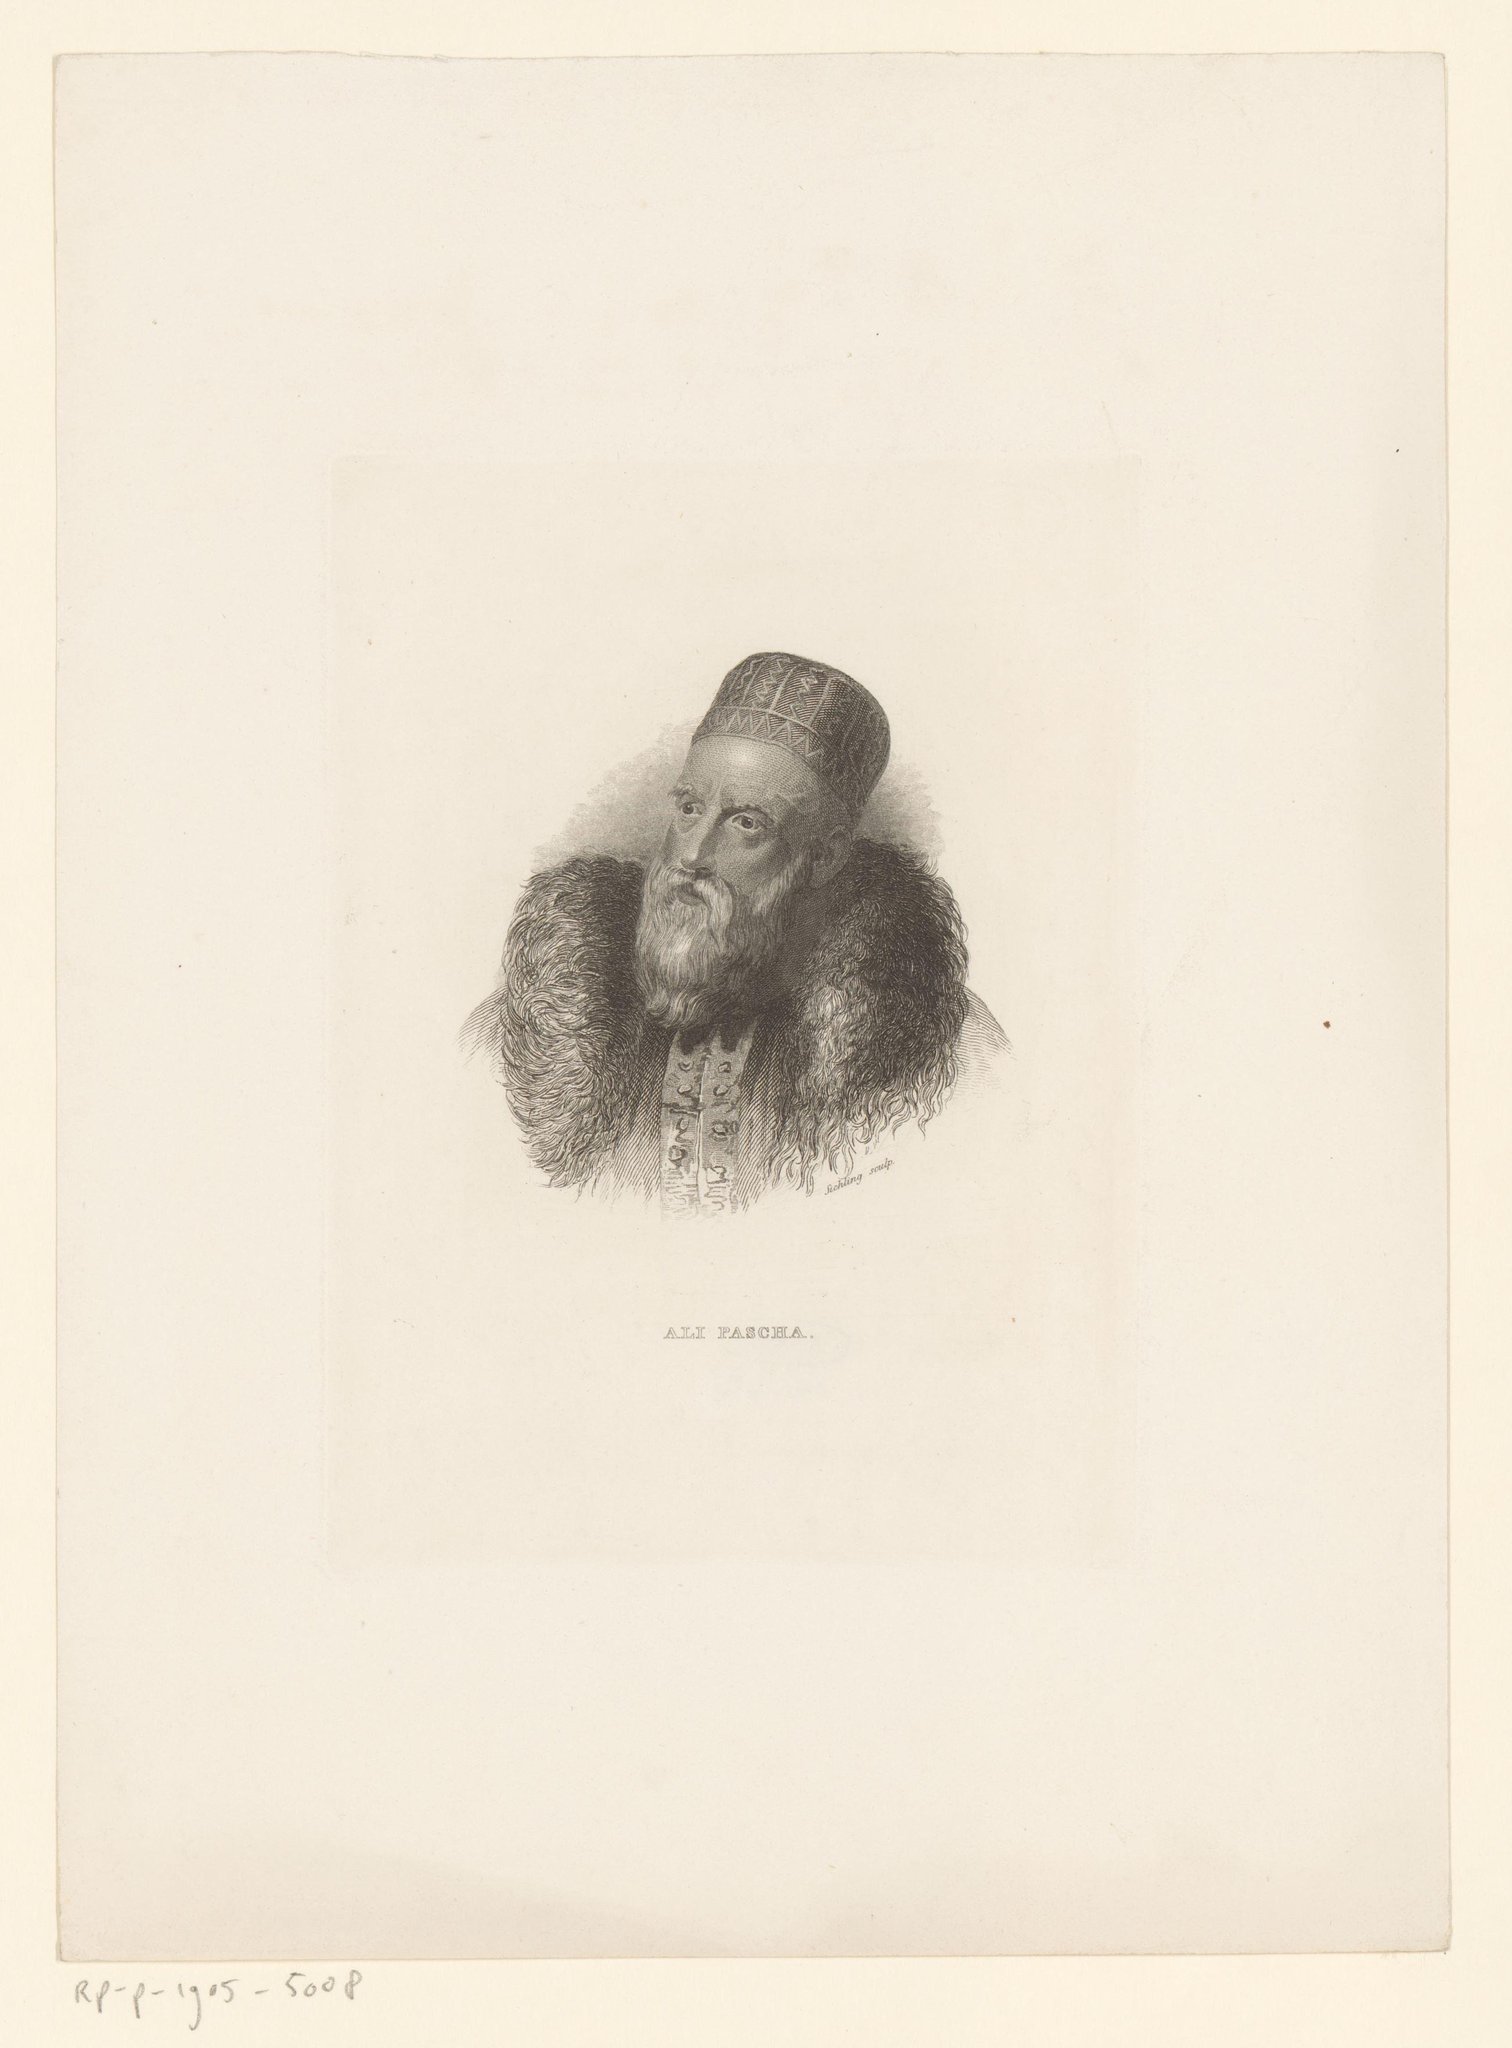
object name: print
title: Portret van Ali Pasja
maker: lazarus gottlieb sichling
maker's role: print maker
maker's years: 1812-1863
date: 1822-1863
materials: paper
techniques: engraving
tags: historical persons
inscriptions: collector's mark: Lugt 2228